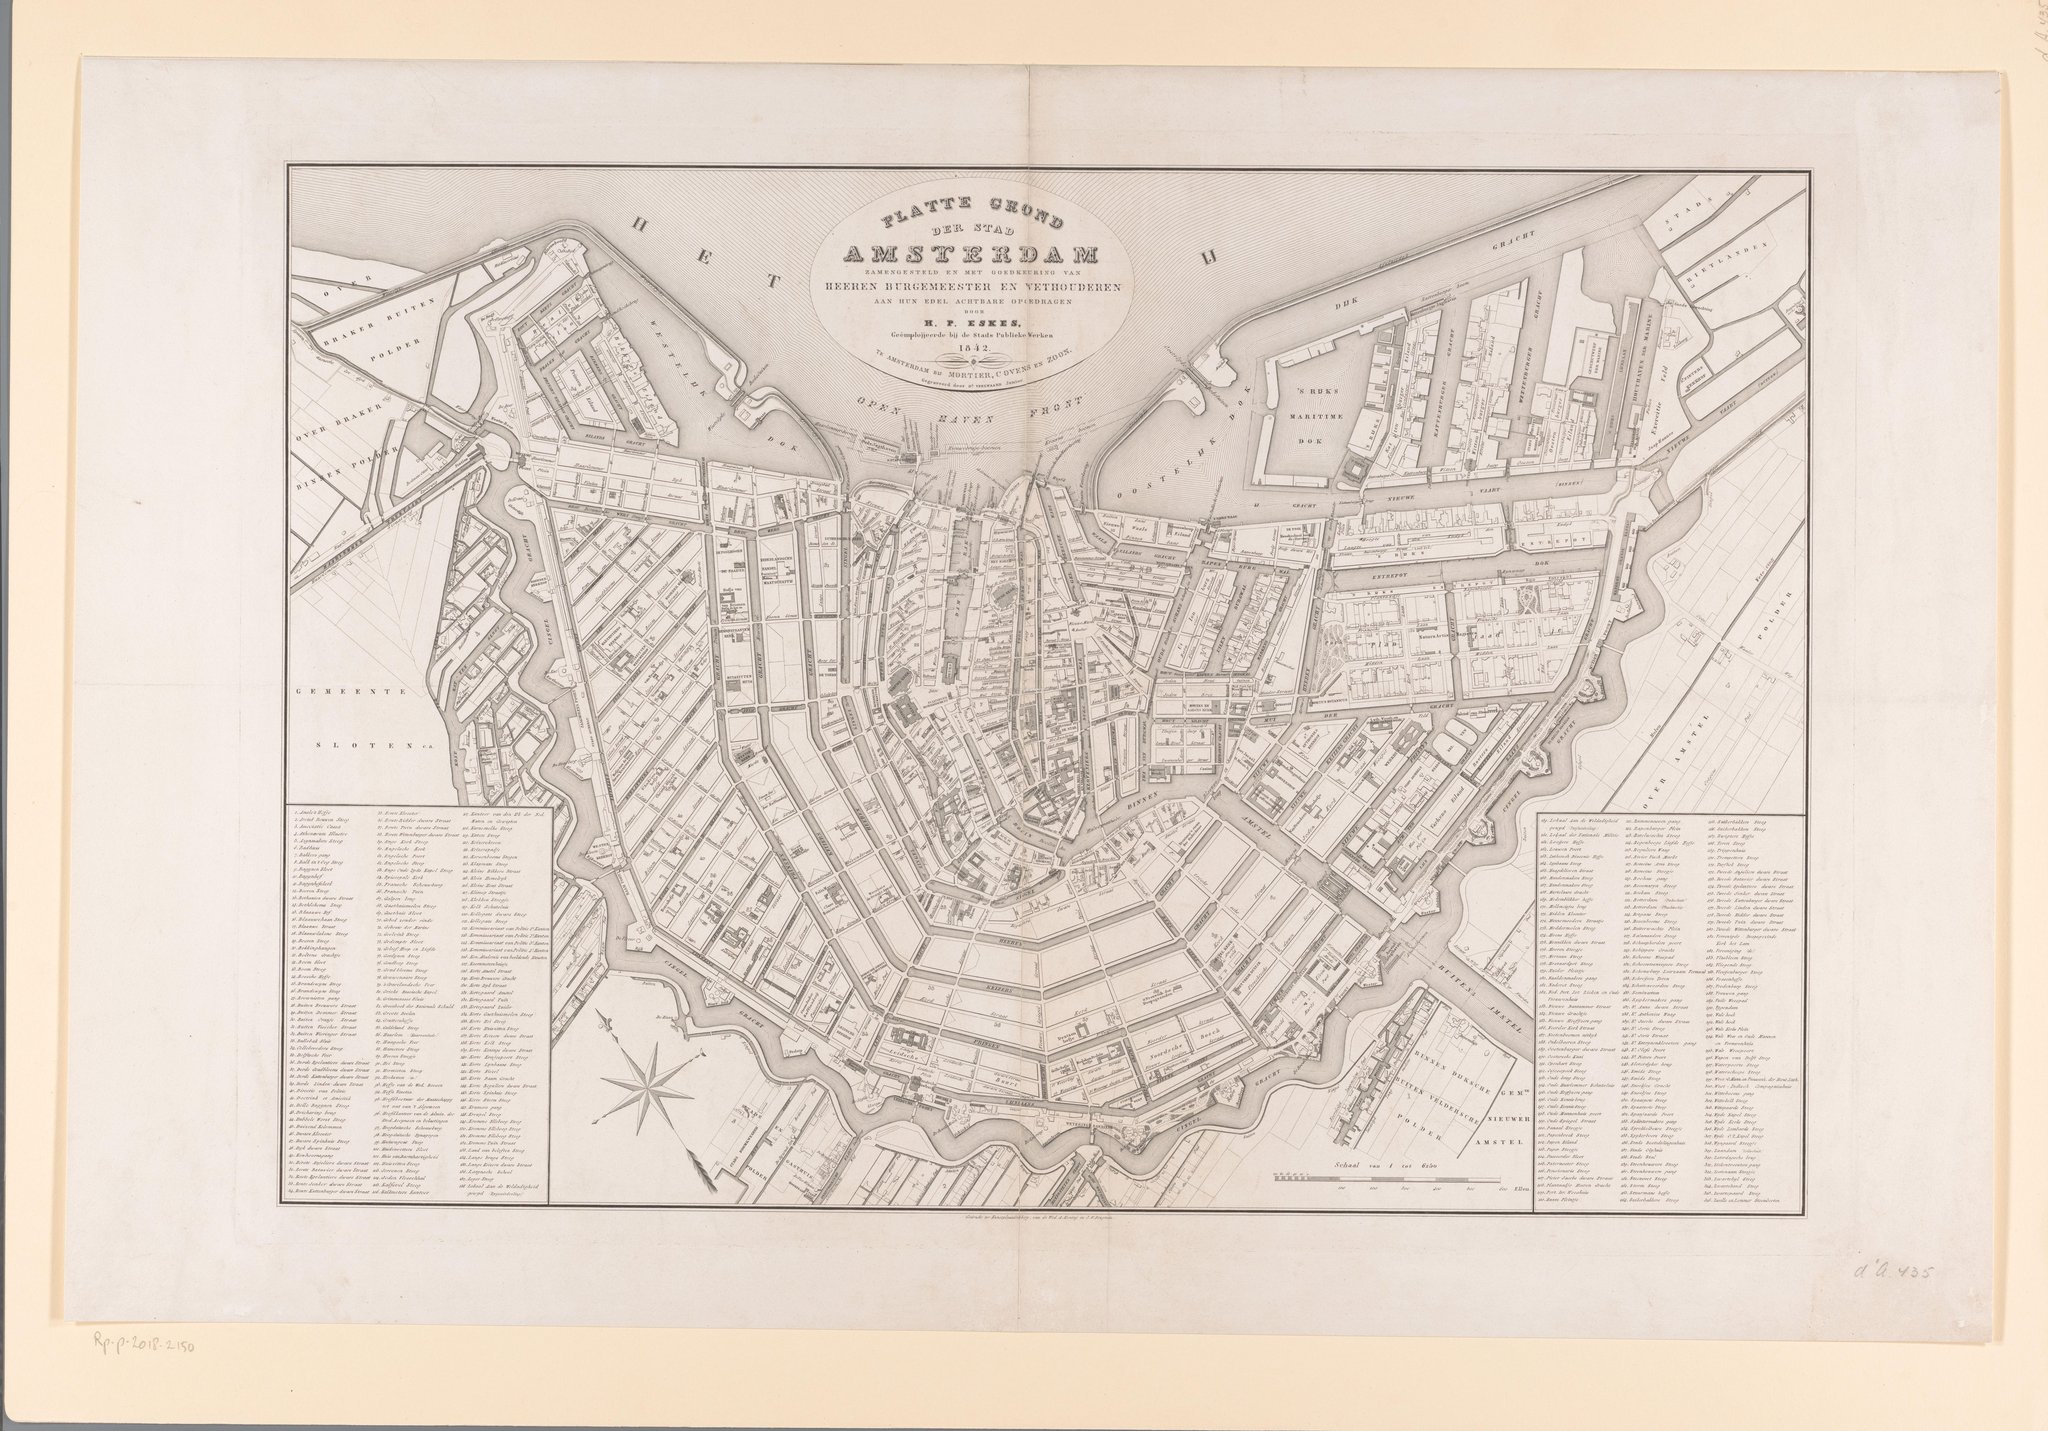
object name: print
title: Plattegrond van Amsterdam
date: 1842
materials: paper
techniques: engraving, etching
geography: amsterdam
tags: maps of separate countries or regions, amsterdam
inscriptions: date